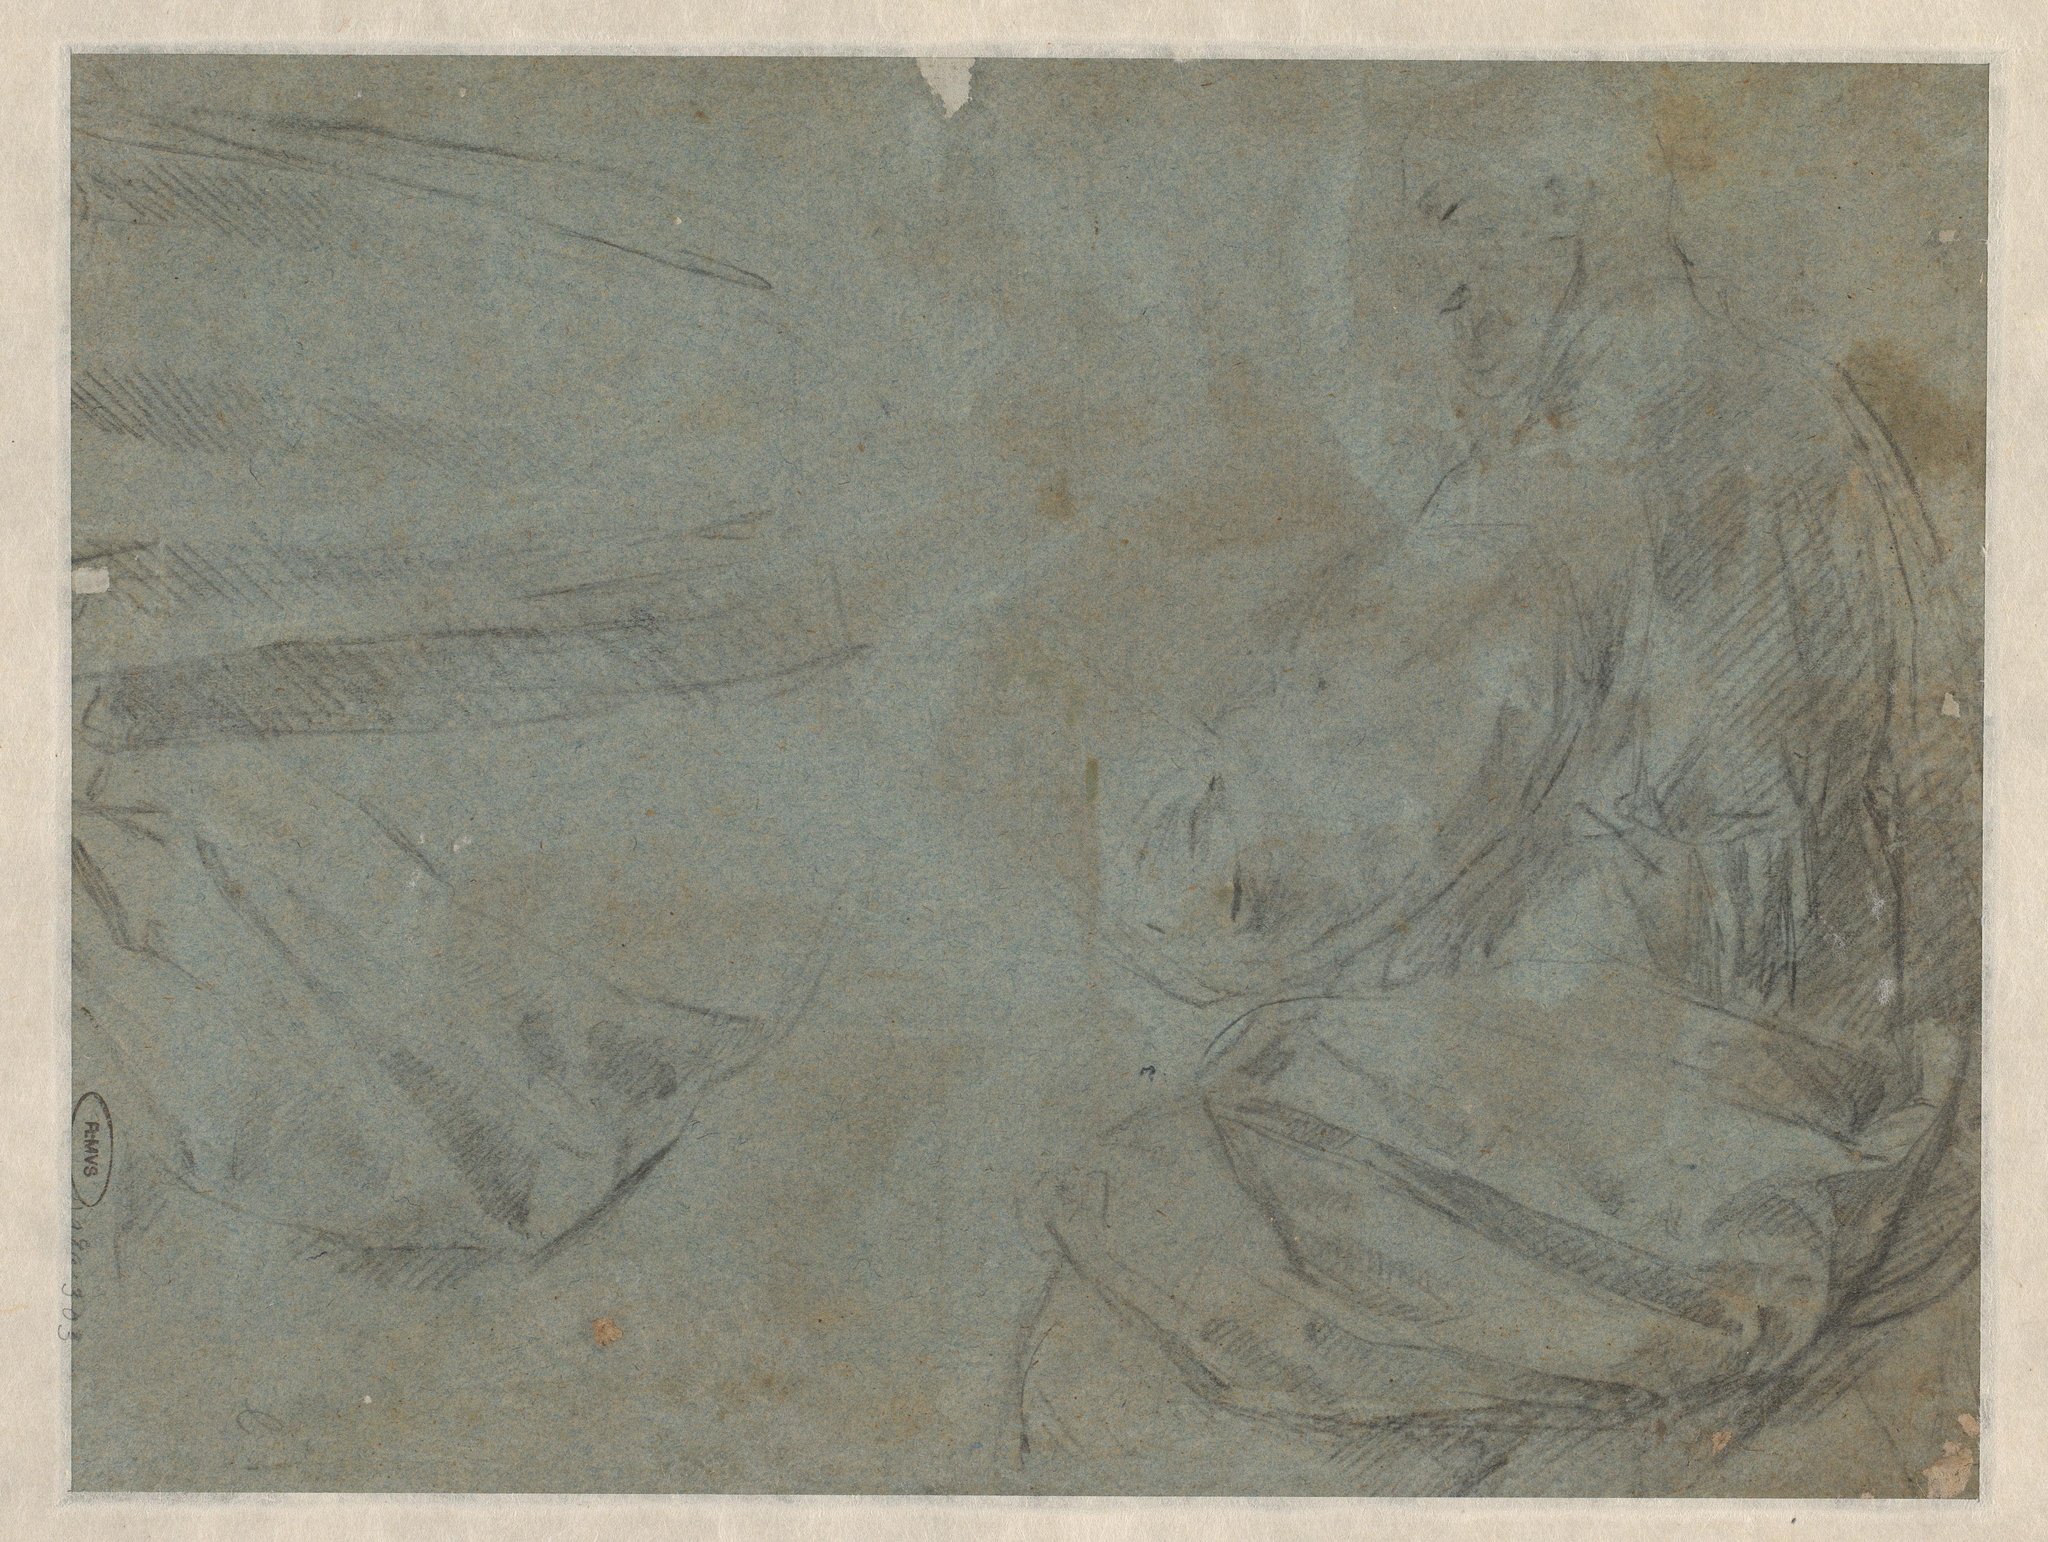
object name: drawing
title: Zittende man en studie van zijn kleding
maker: Anonymous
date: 1550-1599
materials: chalk, paper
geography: emilia